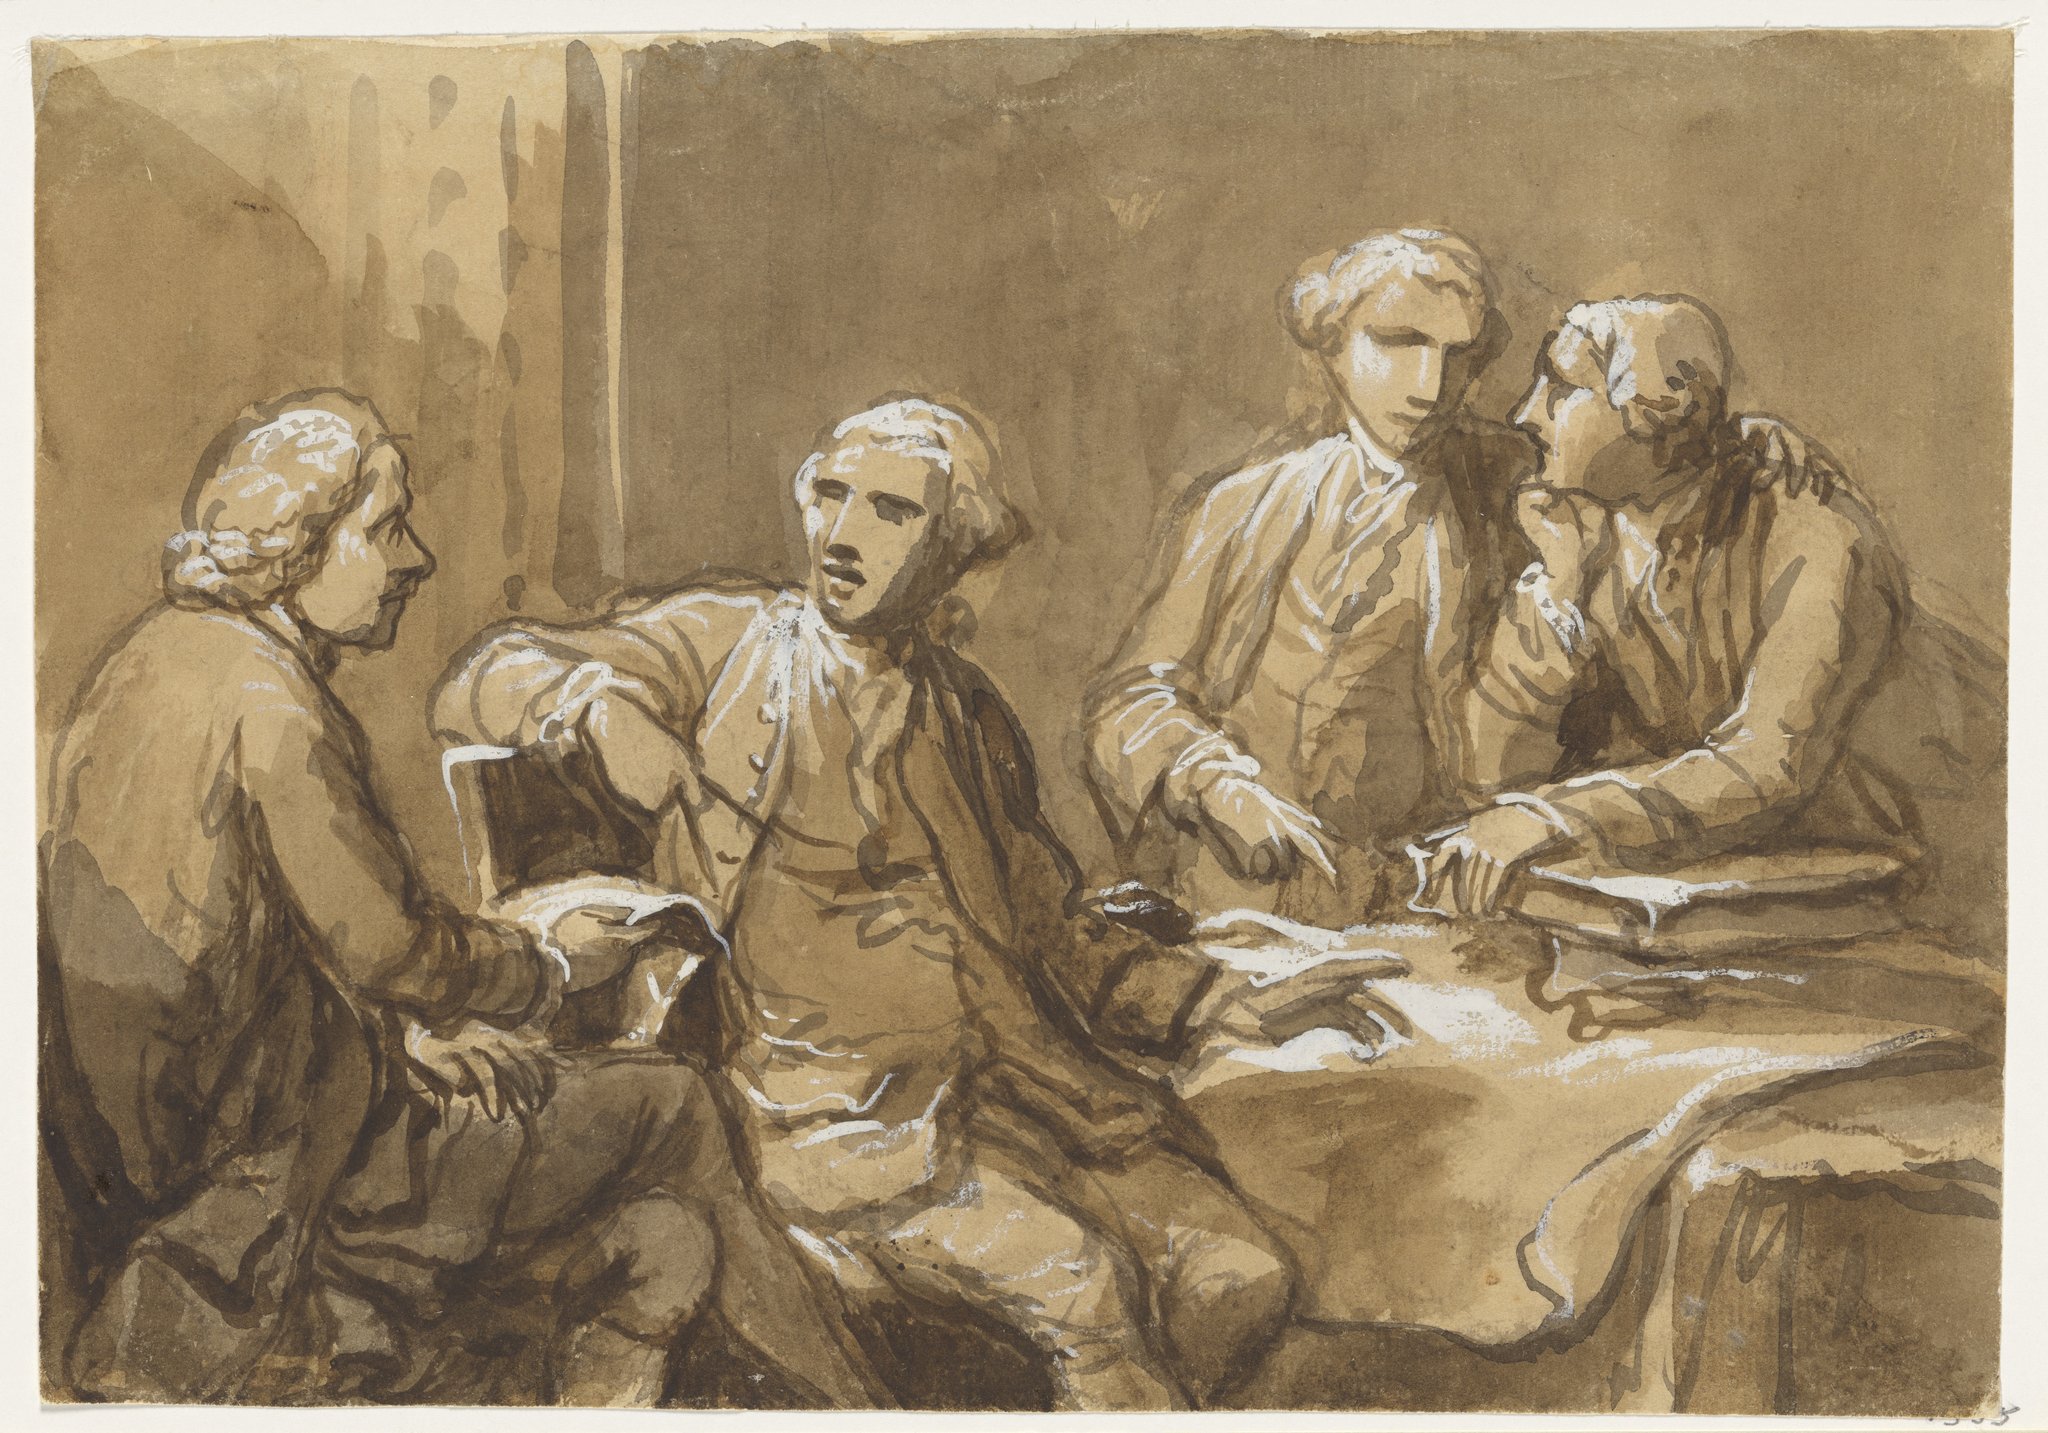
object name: drawing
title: Four Connoisseurs Seated at a Table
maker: antonio zucchi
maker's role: artist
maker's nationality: italian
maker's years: 1726-1796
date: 1767-1800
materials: ink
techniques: heightening, pen, wash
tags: men